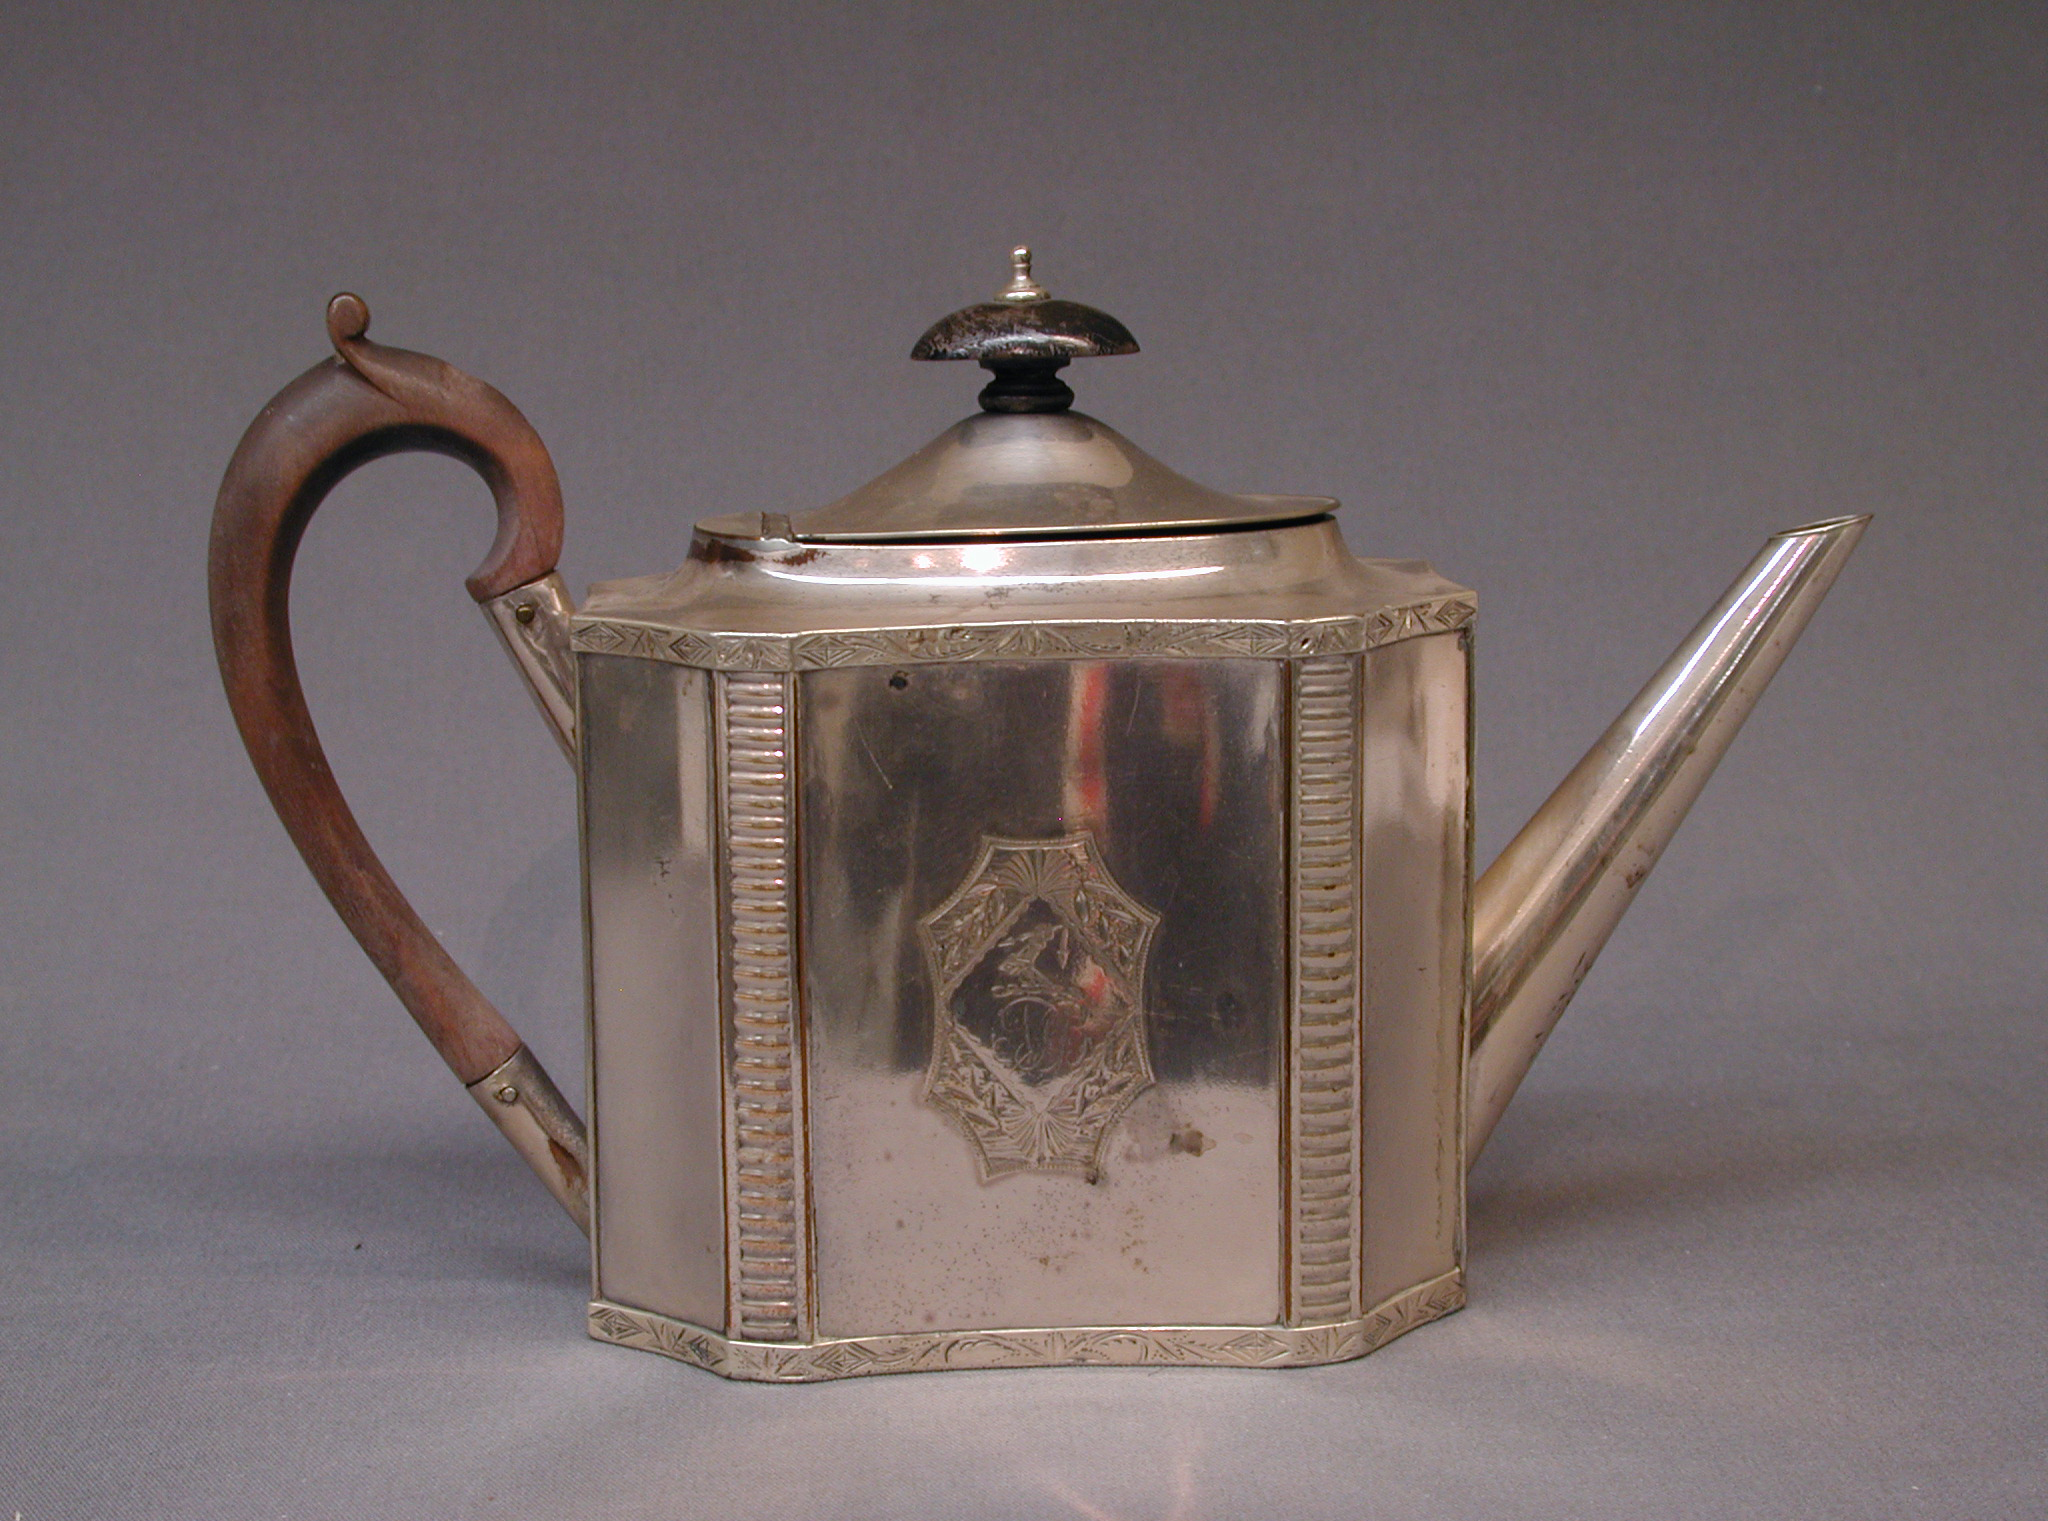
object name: teapot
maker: nathaniel smith and company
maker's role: maker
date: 1787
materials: metal, wood